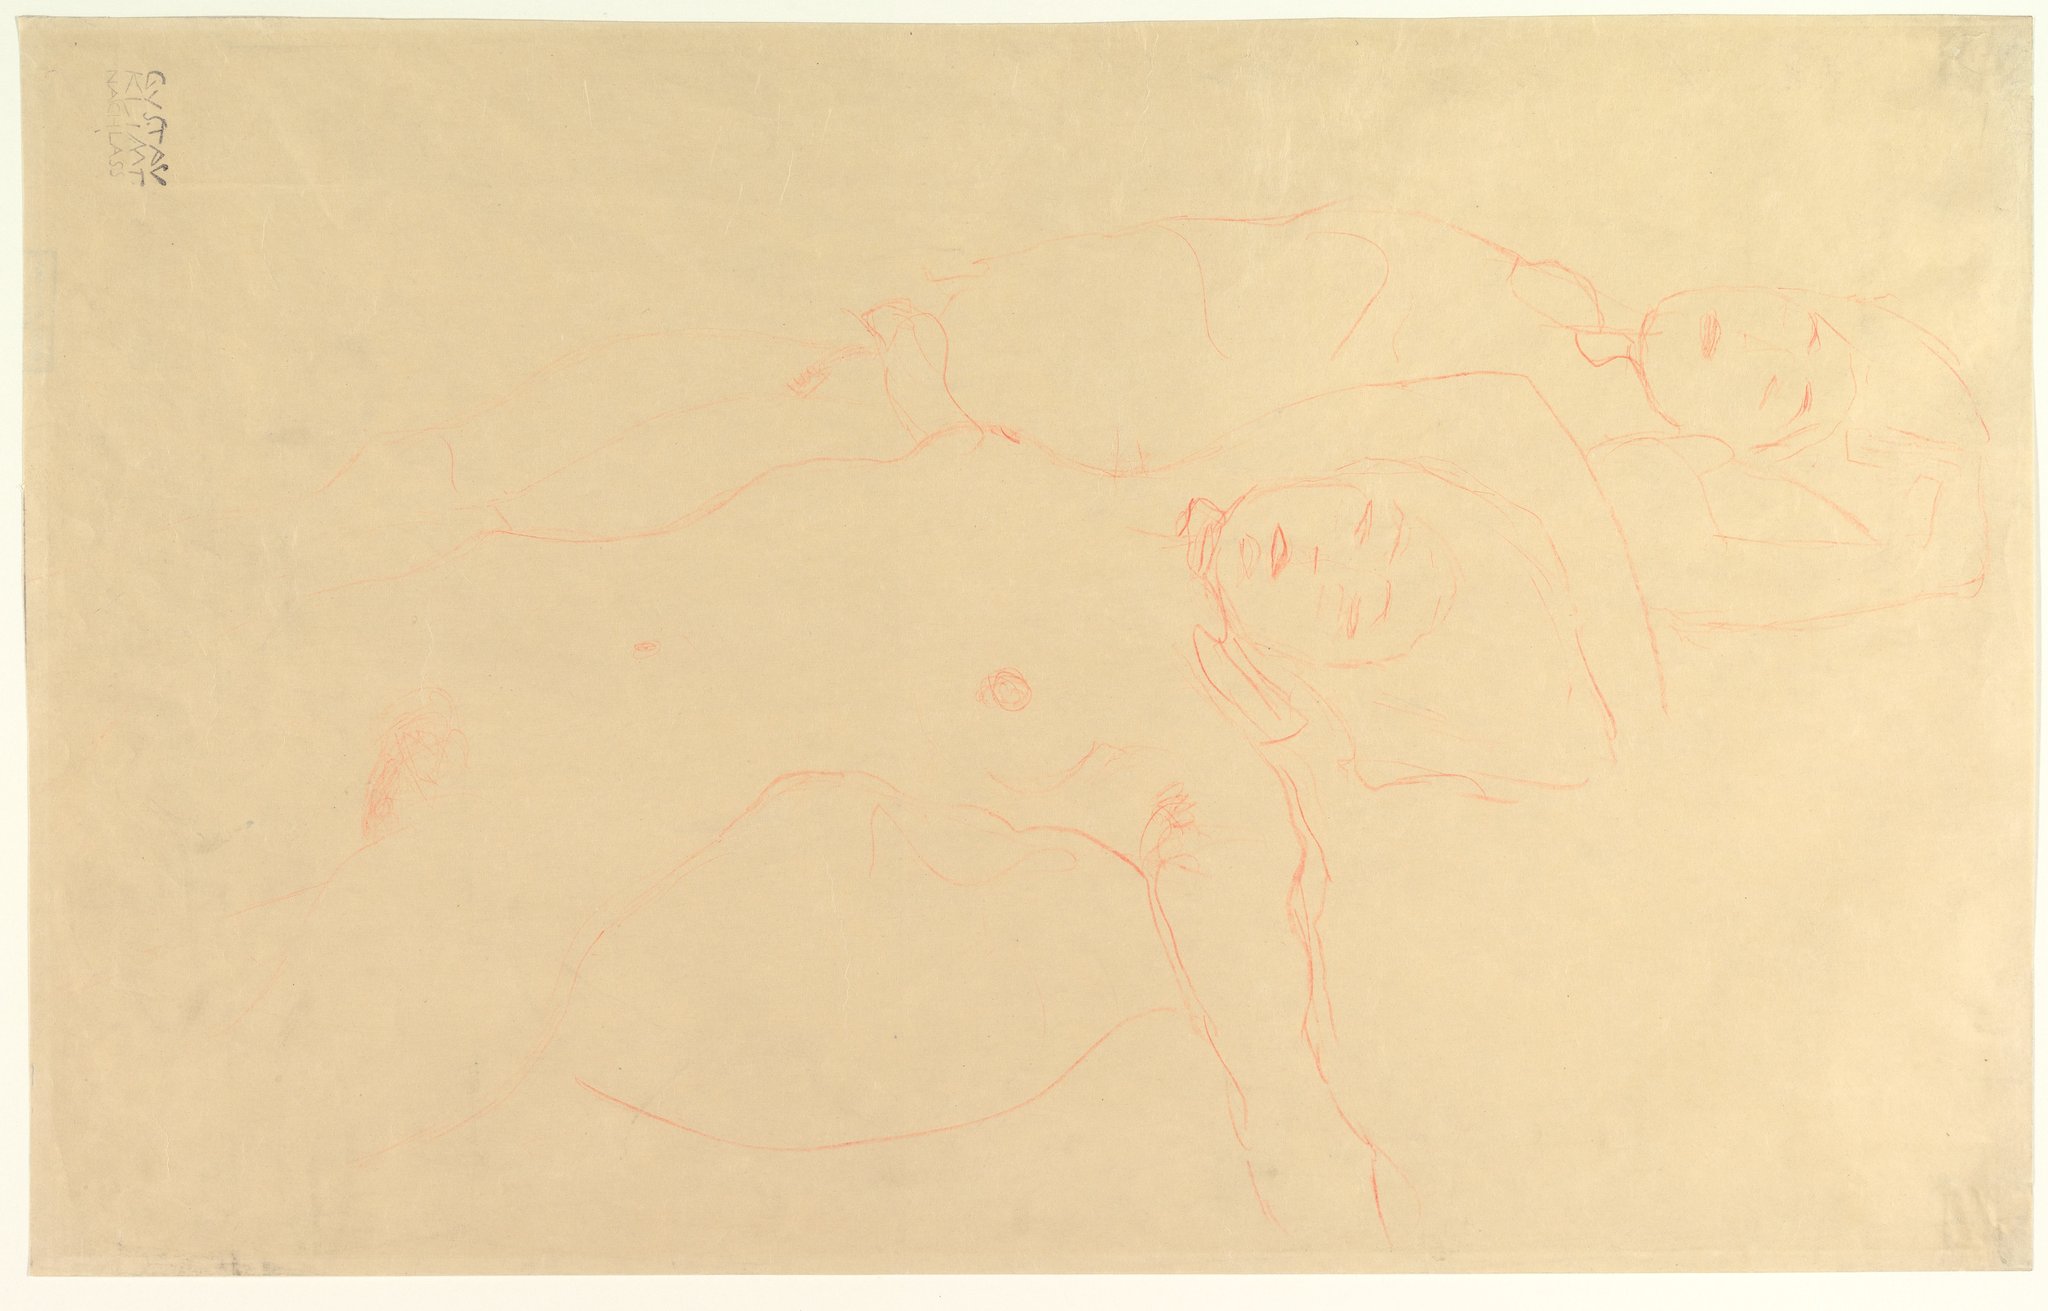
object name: drawing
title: Two Reclining Nudes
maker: gustav klimt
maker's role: artist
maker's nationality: austrian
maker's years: 1862-1918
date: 1905-1906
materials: pencil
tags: human figures,abstraction